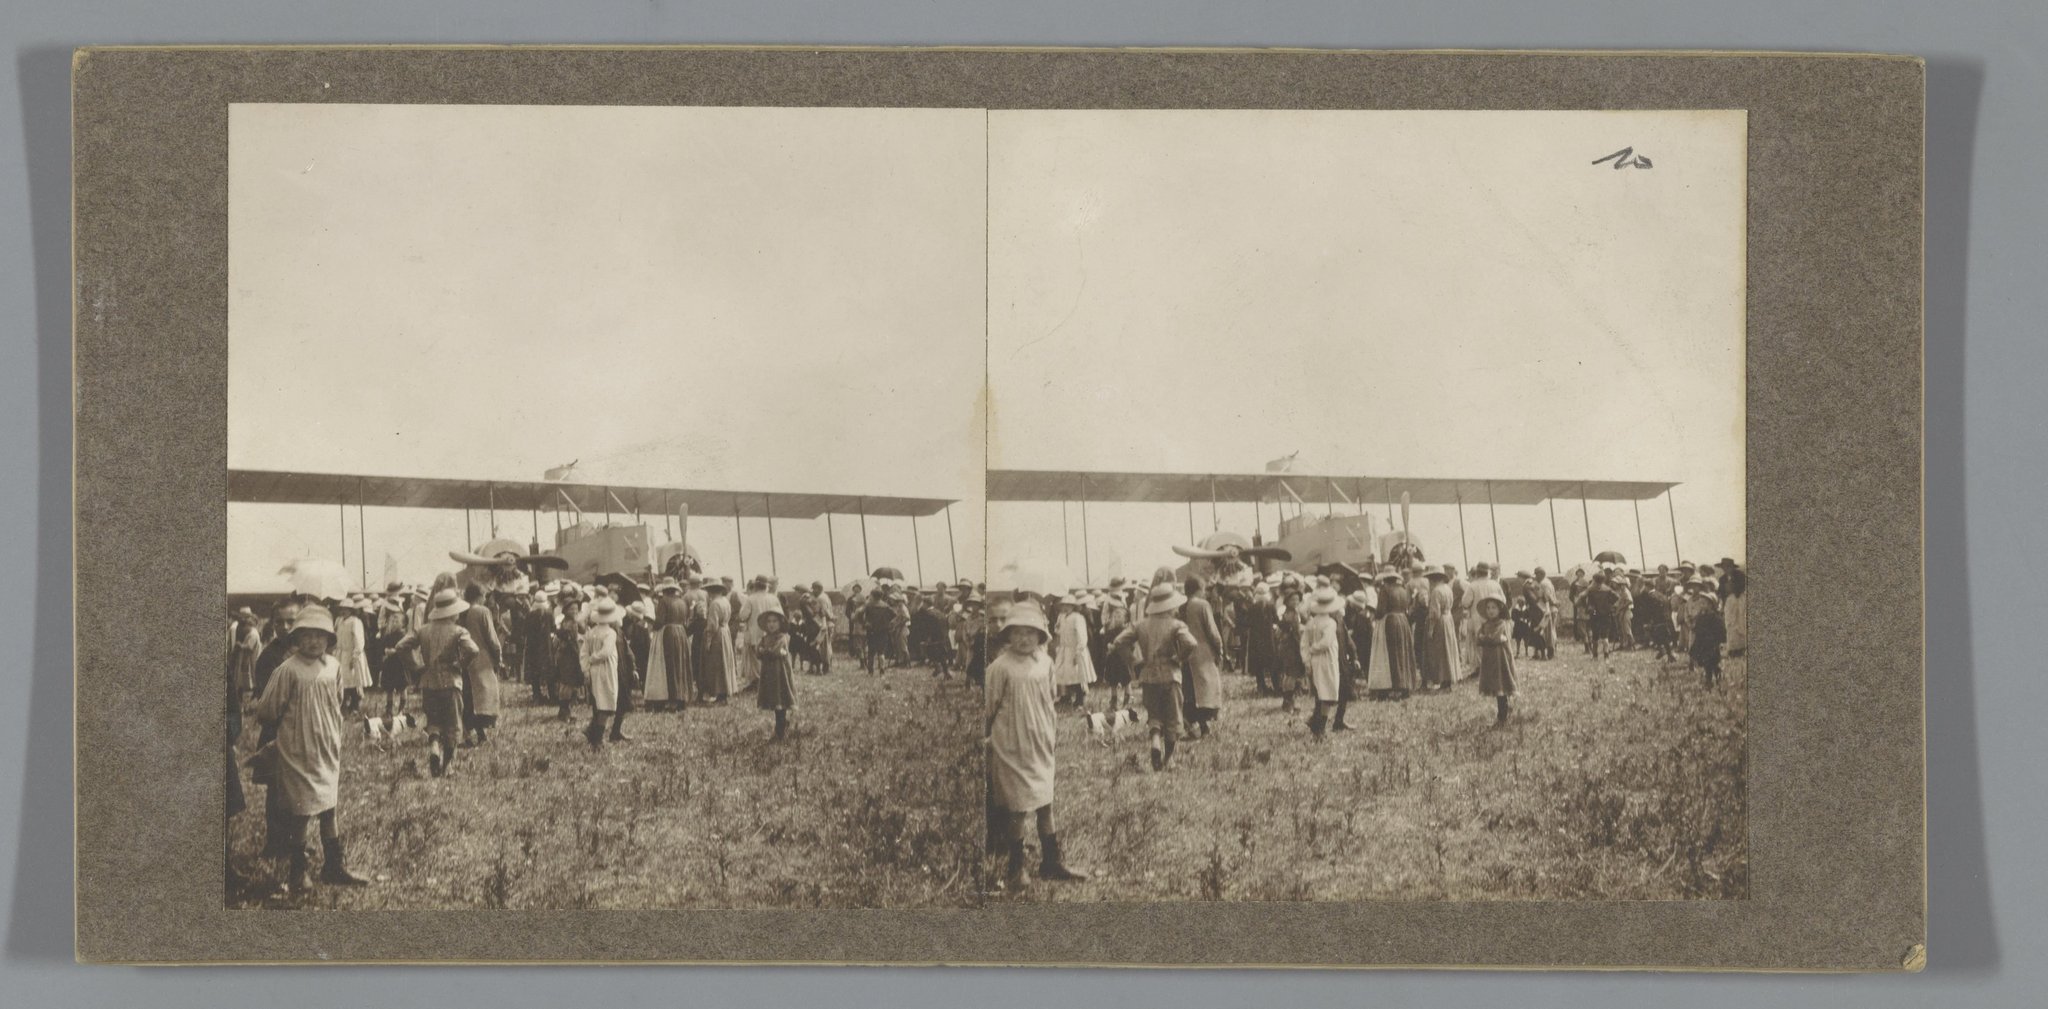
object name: stereograph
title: Italiaans Caproni 3 vliegtuig in een weiland, omringd door toeschouwers, Is-sur-Tille, Frankrijk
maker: Anonymous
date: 1908-1916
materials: paper, cardboard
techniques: collodion silver print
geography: is-sur-tille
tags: aircraft, aeroplane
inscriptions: number: ‘10’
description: De Caproni 3 was een Italiaanse bommenwerper tijdens de Eerste Wereldoorlog (1914-1918).